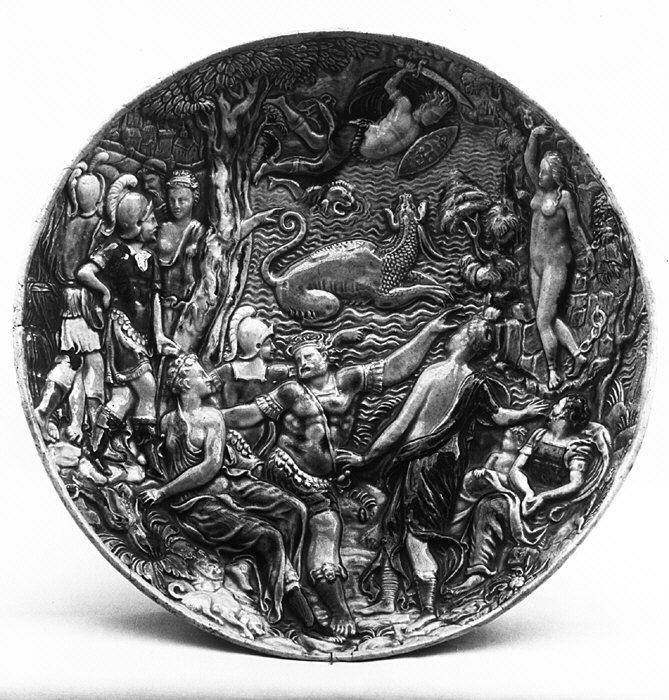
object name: dish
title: Dish with scene from myth of Perseus and Andromeda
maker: bernard palissy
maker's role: maker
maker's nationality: french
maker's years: 1510-1590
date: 1601-1700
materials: earthenware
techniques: glazing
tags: soldiers,female nudes,andromeda,perseus